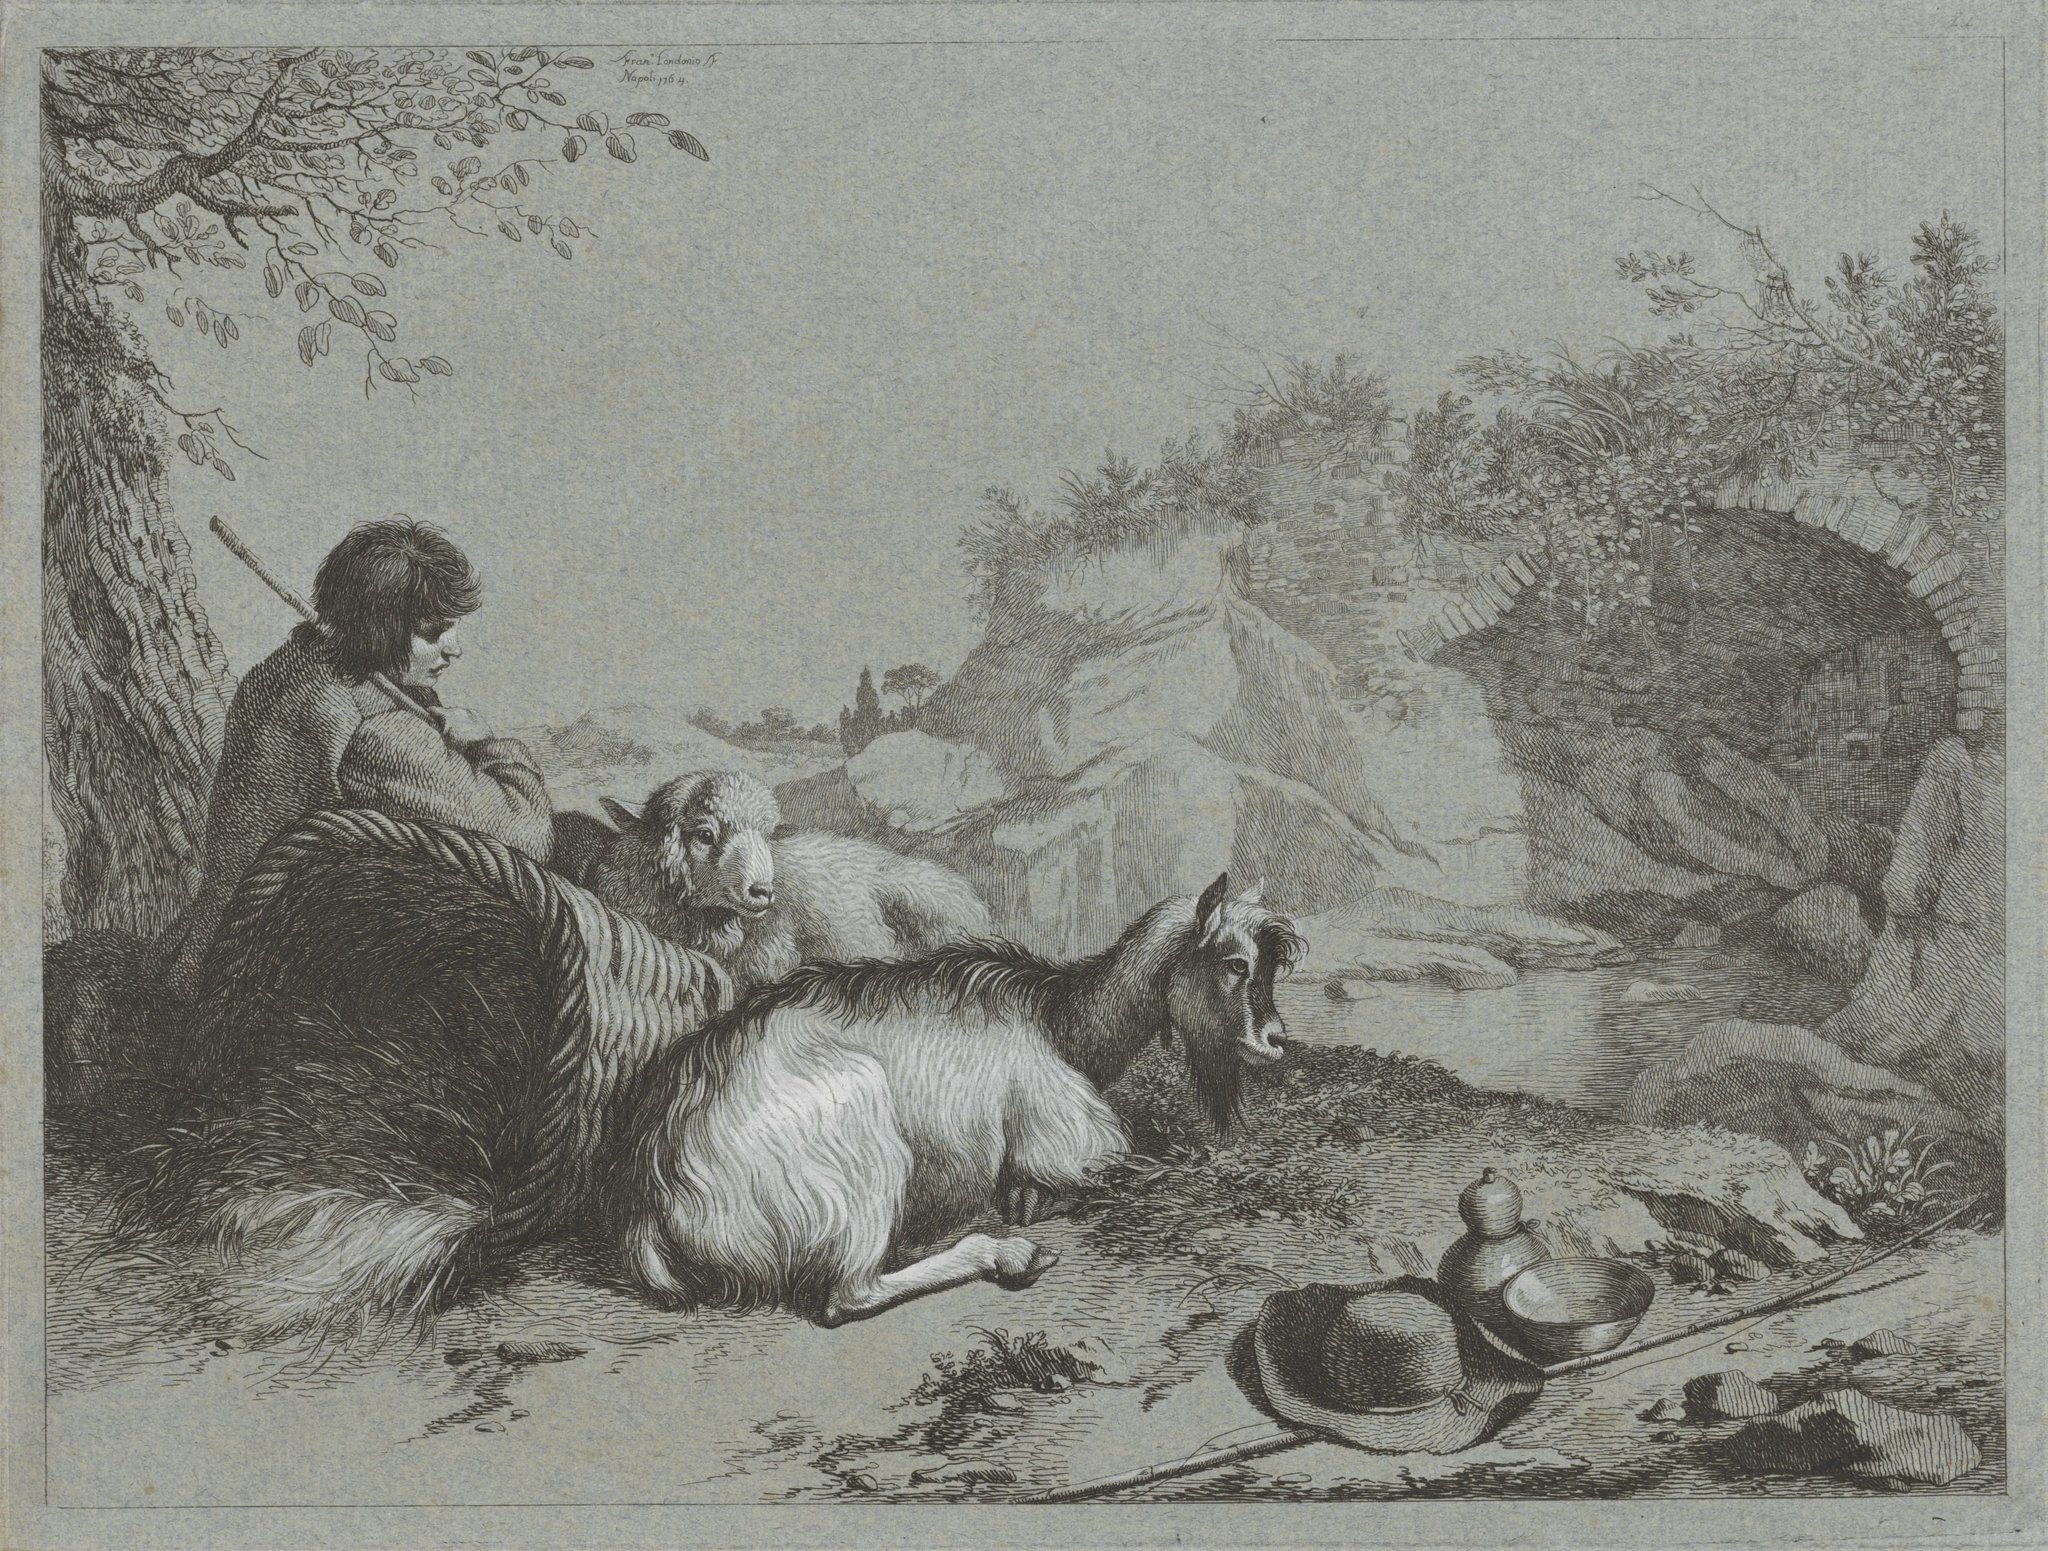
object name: print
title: Herdertaferelen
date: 1763-1764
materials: paper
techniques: etching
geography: italy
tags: cow, herding, herdsman, herdswoman, shepherd, shepherdess, cowherd, etc., sheep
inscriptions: collector's mark: Lugt 240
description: Een herder met een schaap en een geit in een landschap. Op de achtergrond rechts een grot.